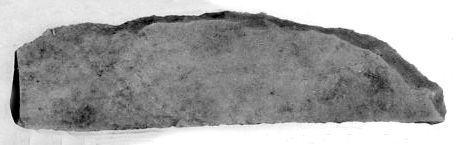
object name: tool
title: Tool (?)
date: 1295-1070 BCE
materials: stone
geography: egypt